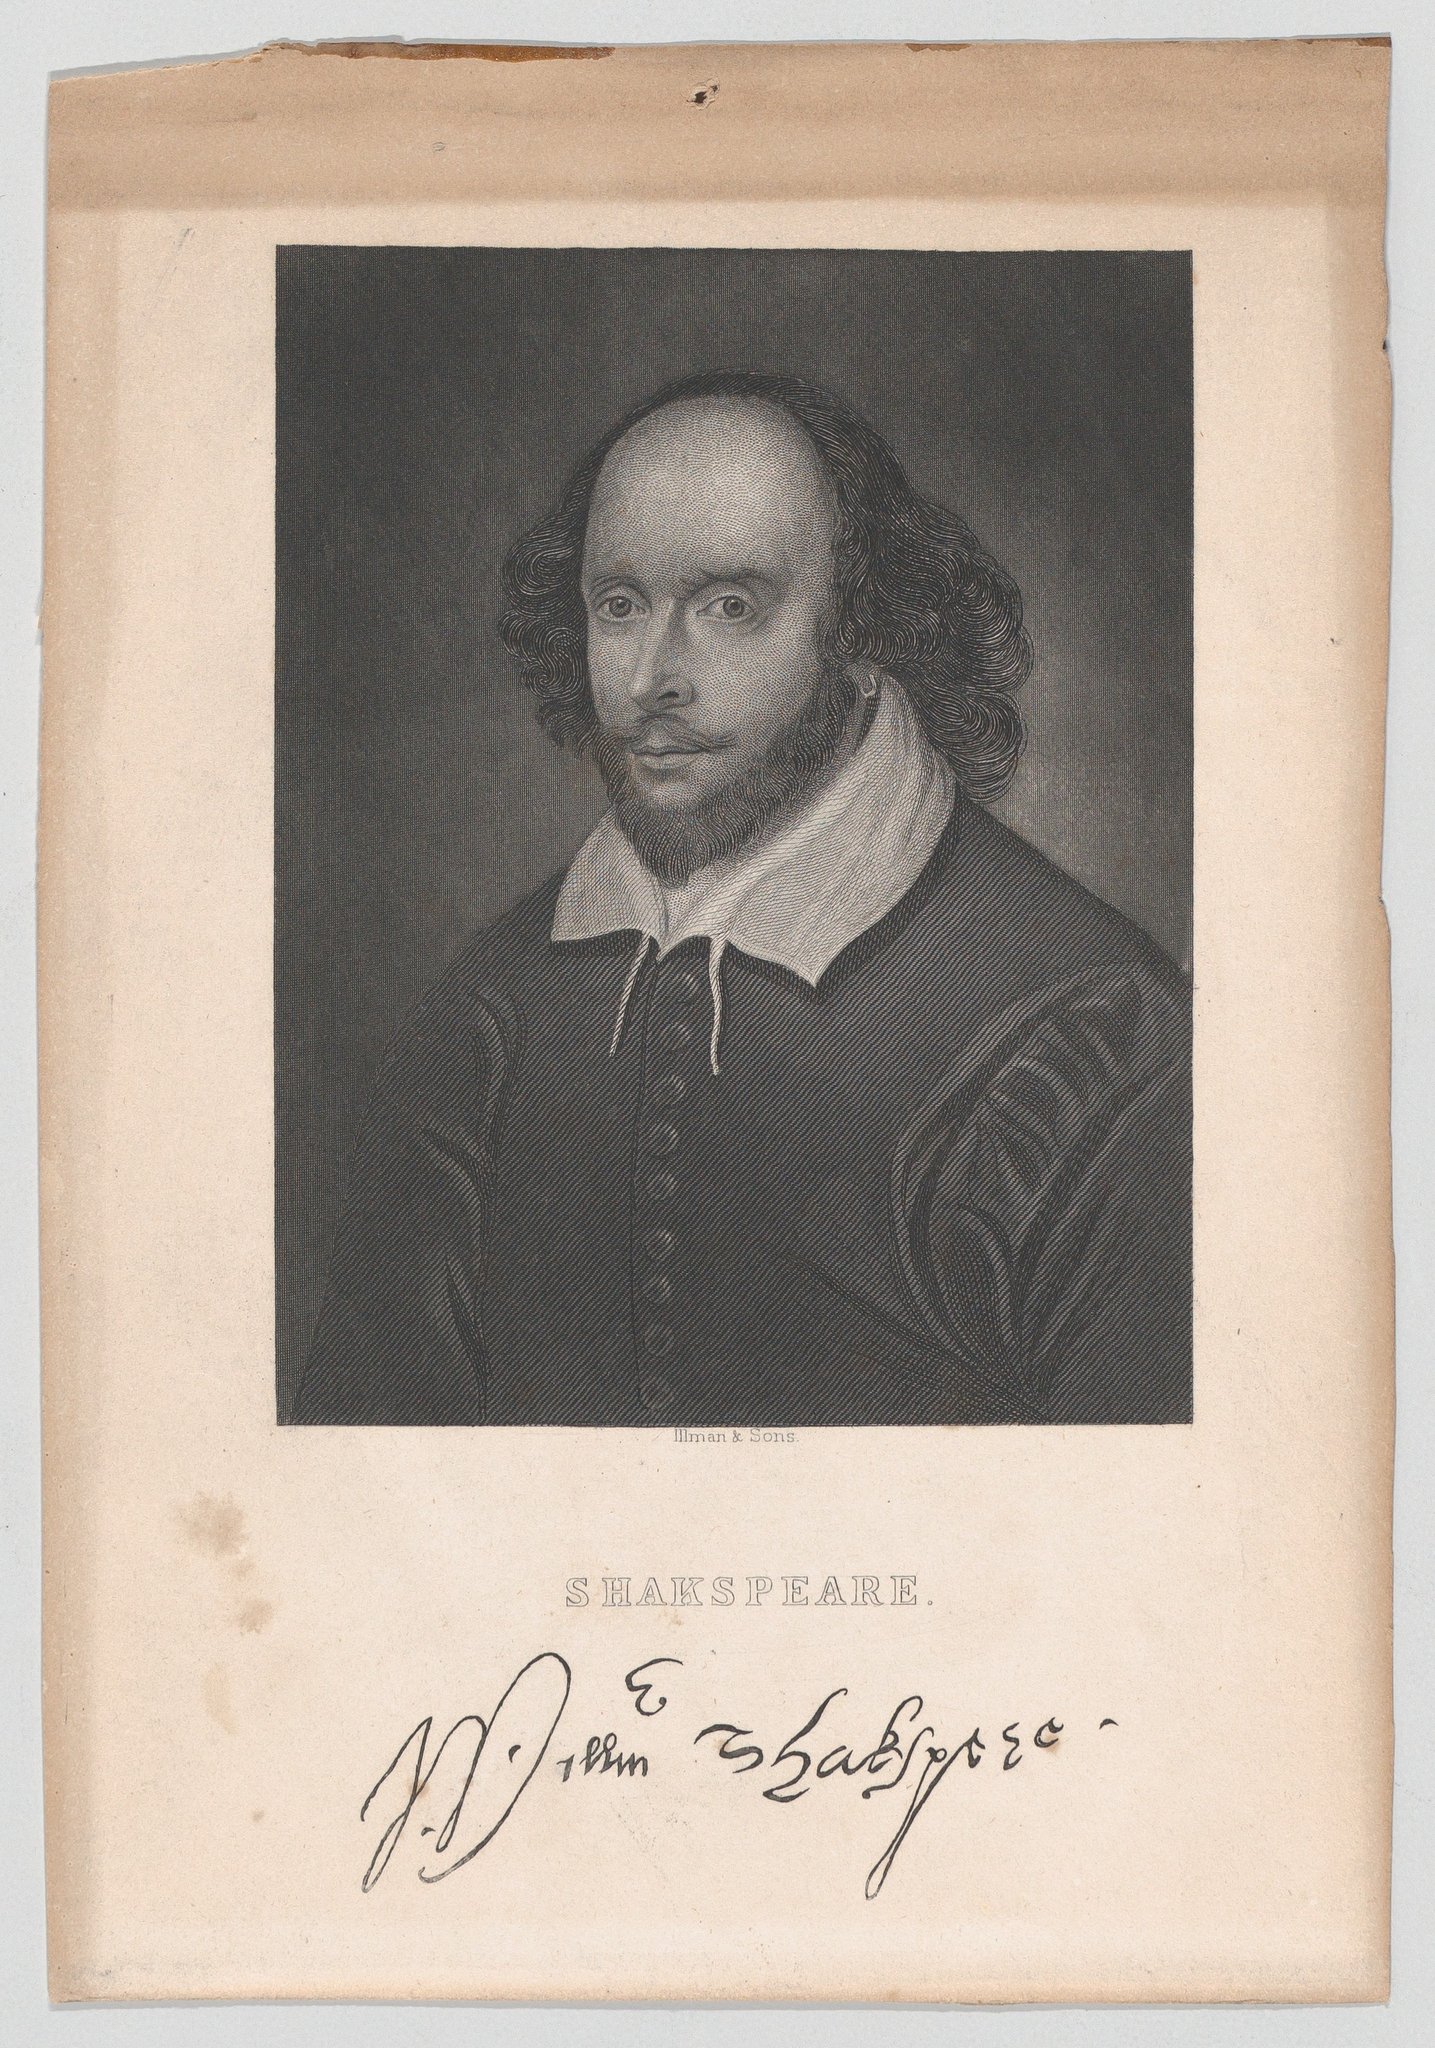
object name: print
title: William Shakespeare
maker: illman and sons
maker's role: publisher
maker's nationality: american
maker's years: 1800-1900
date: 1834-1866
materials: steel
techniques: engraving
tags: shakespeare,men,portraits